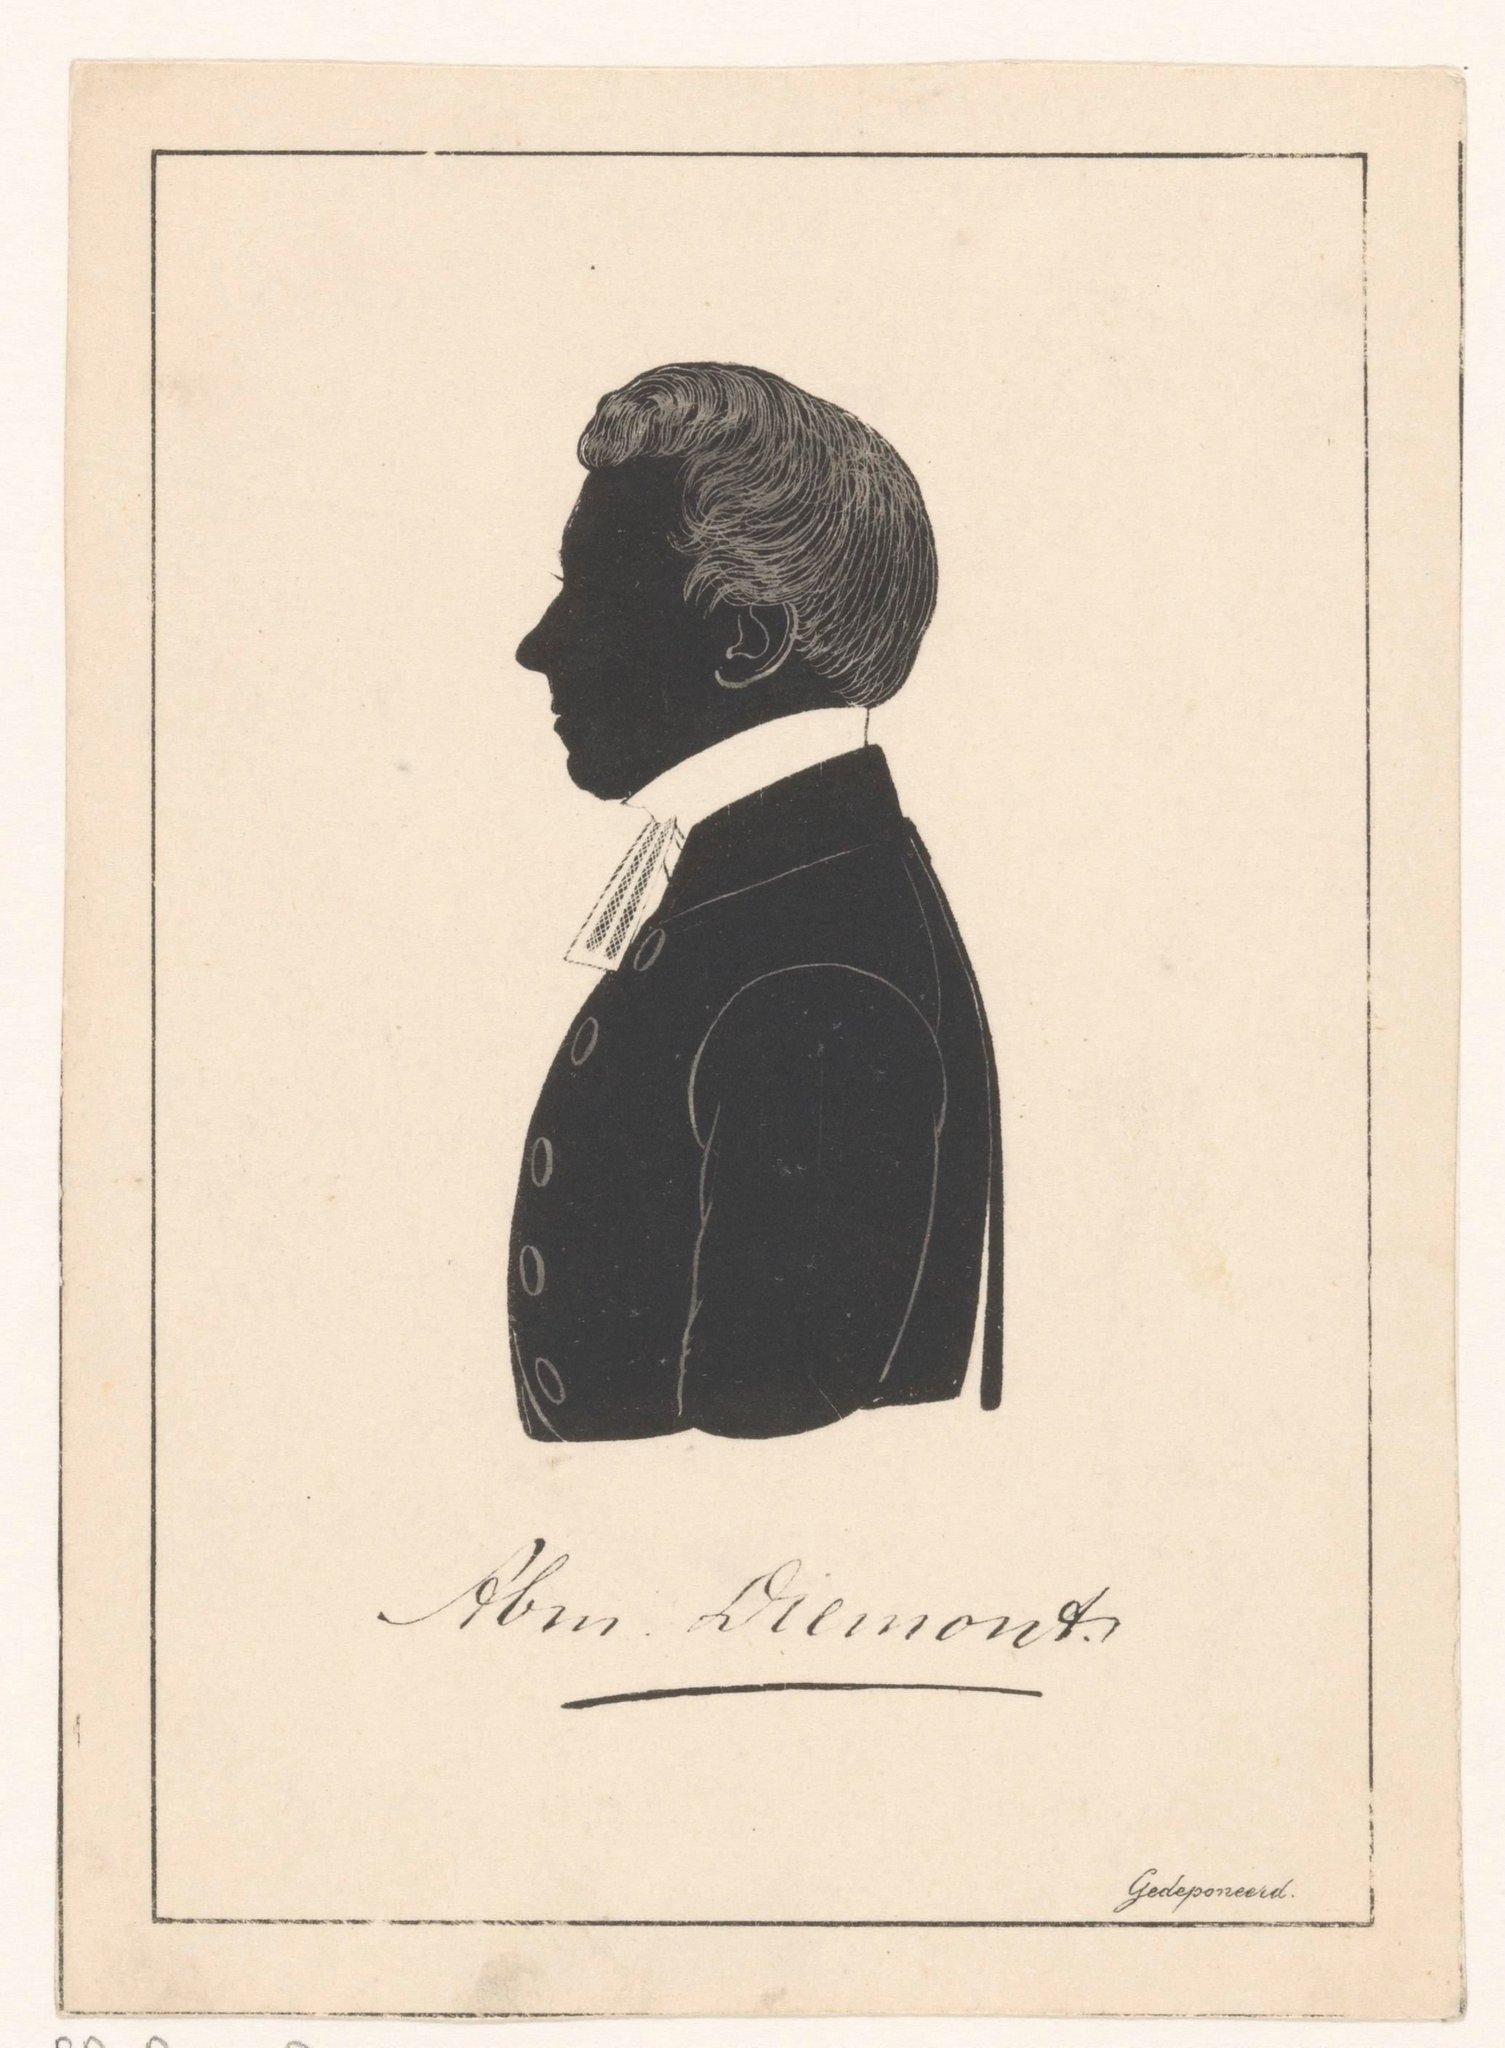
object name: print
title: Silhouetportret van Abraham Diemont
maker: friedrich heinrich wilhelm schröder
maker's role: draughtsman, print maker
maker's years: 1818-1870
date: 1833-1870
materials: paper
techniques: hand coloring, lithograph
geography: netherlands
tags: arnhem, historical persons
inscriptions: collector's mark: Lugt 2228, : ‘Gedeponeerd.’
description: Onder het portret de signatuur van de geportretteerde.